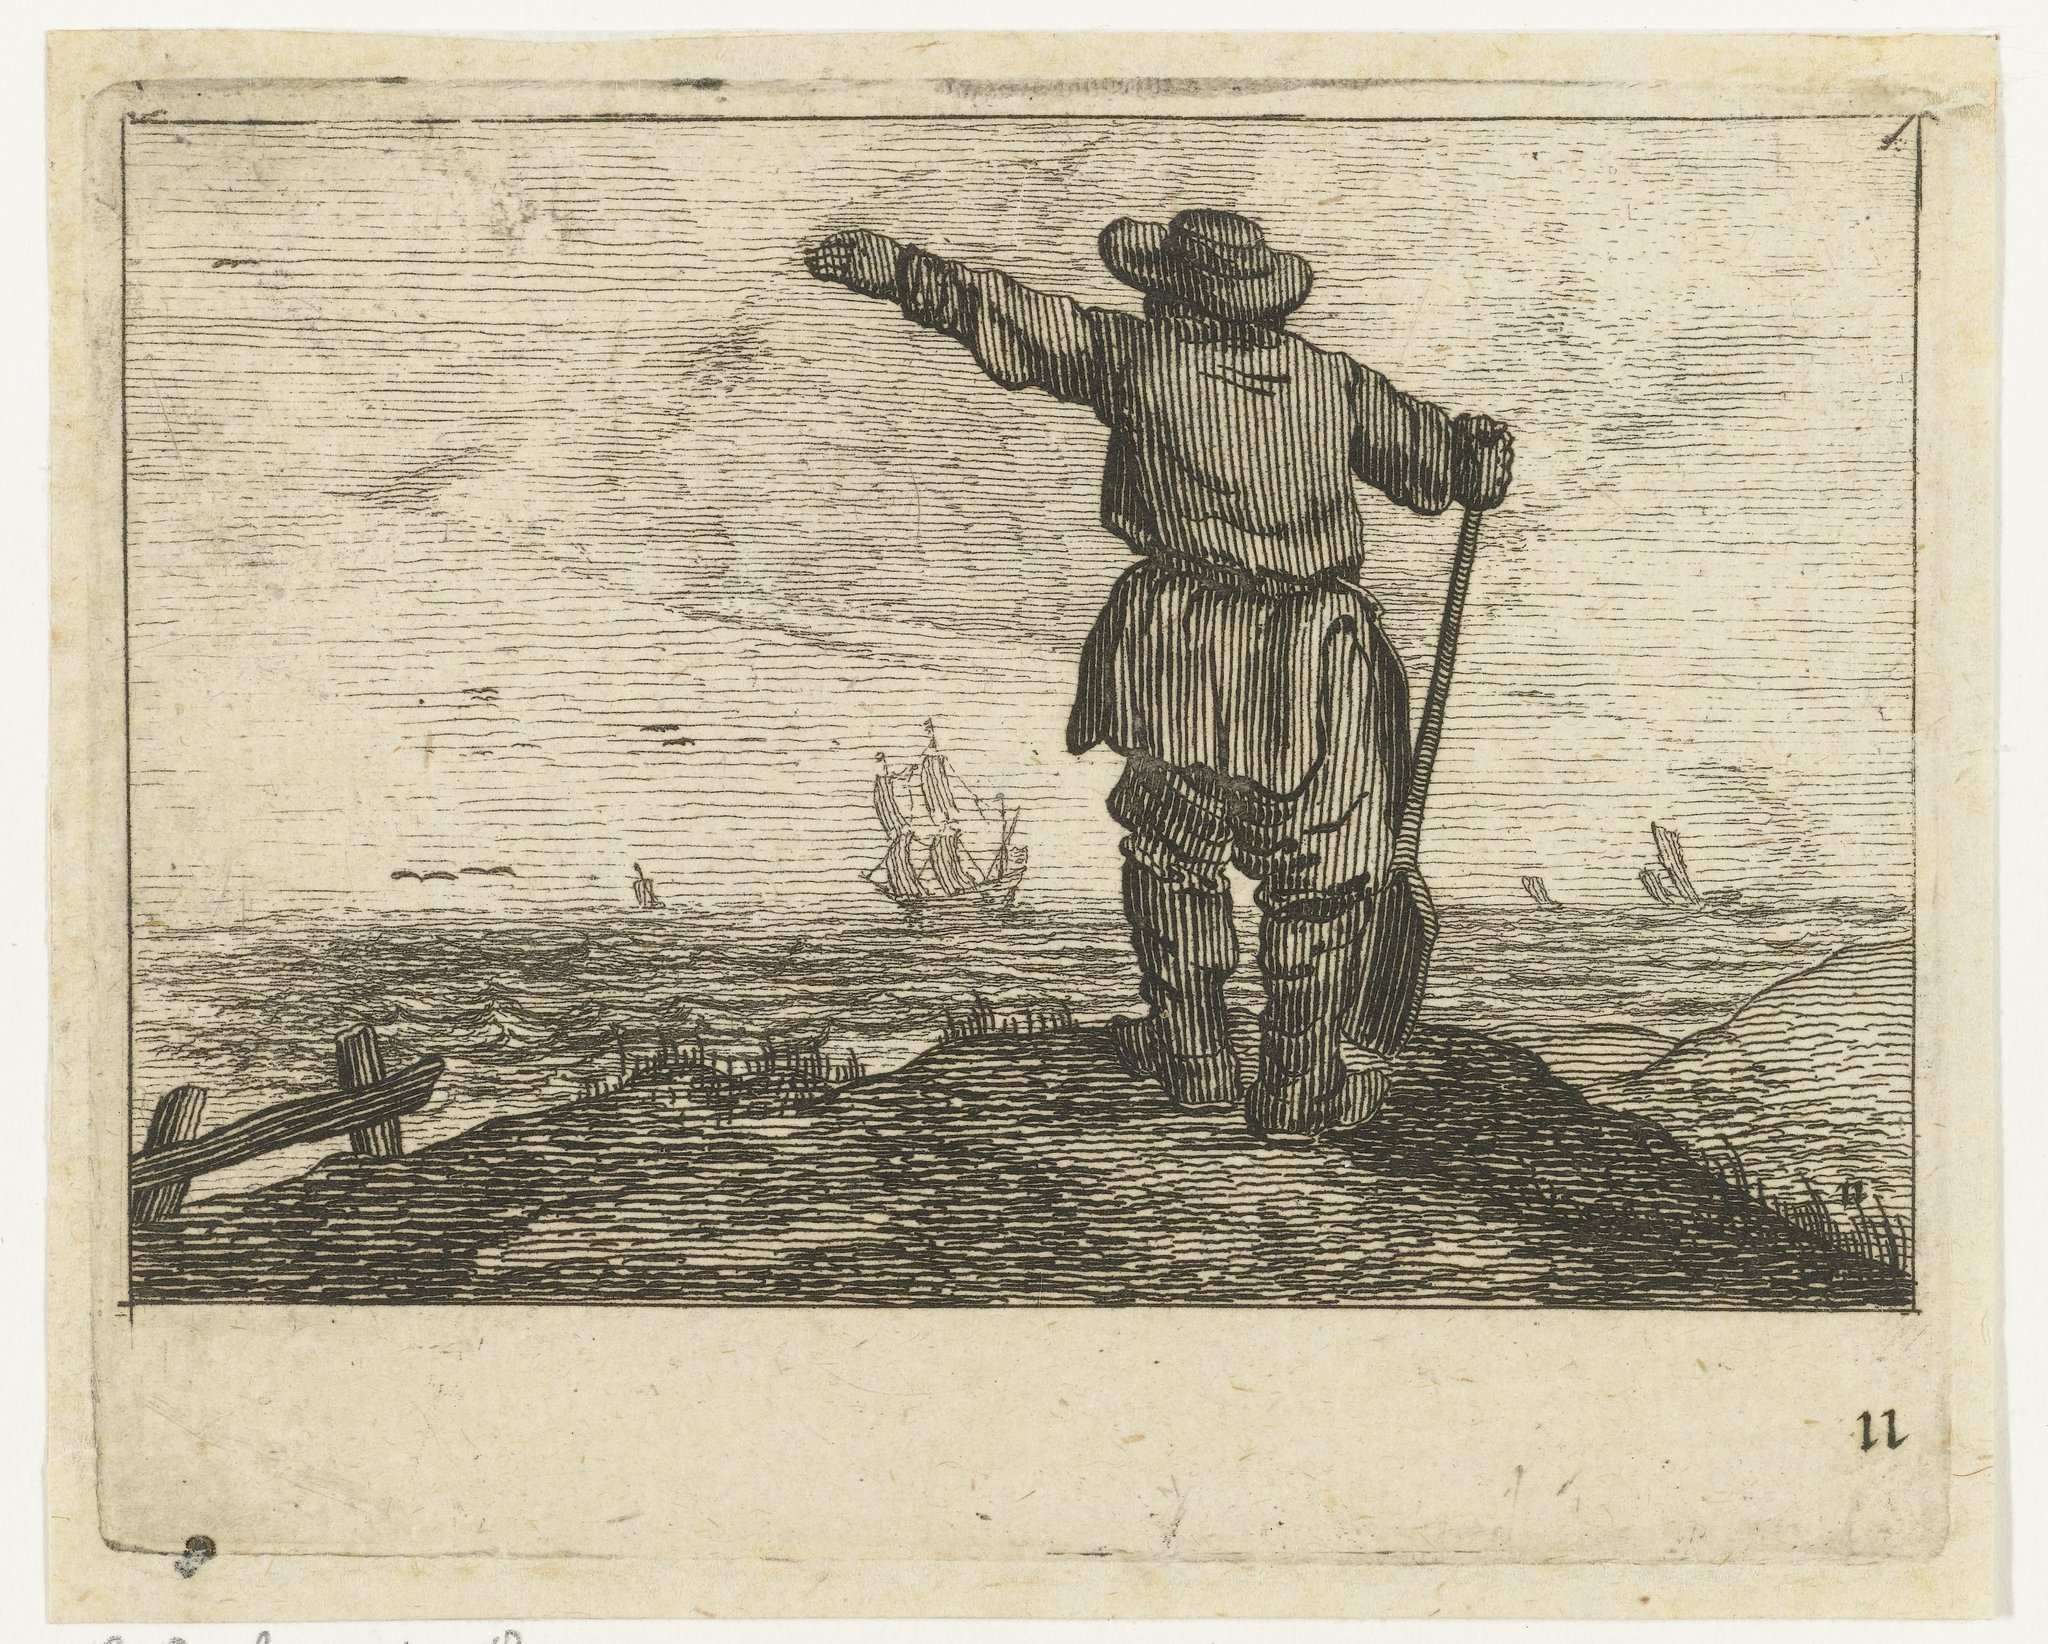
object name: print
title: Duinlandschap met een zwaaiende man, leunend op een schop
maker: gillis van scheyndel (i)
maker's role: draughtsman, print maker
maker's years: 1595-1660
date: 1645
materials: paper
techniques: etching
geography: northern netherlands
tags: dune coast, agricultural implements: spade, waving farewell ~ departure on a journey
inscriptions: collector's mark: Lugt 2228